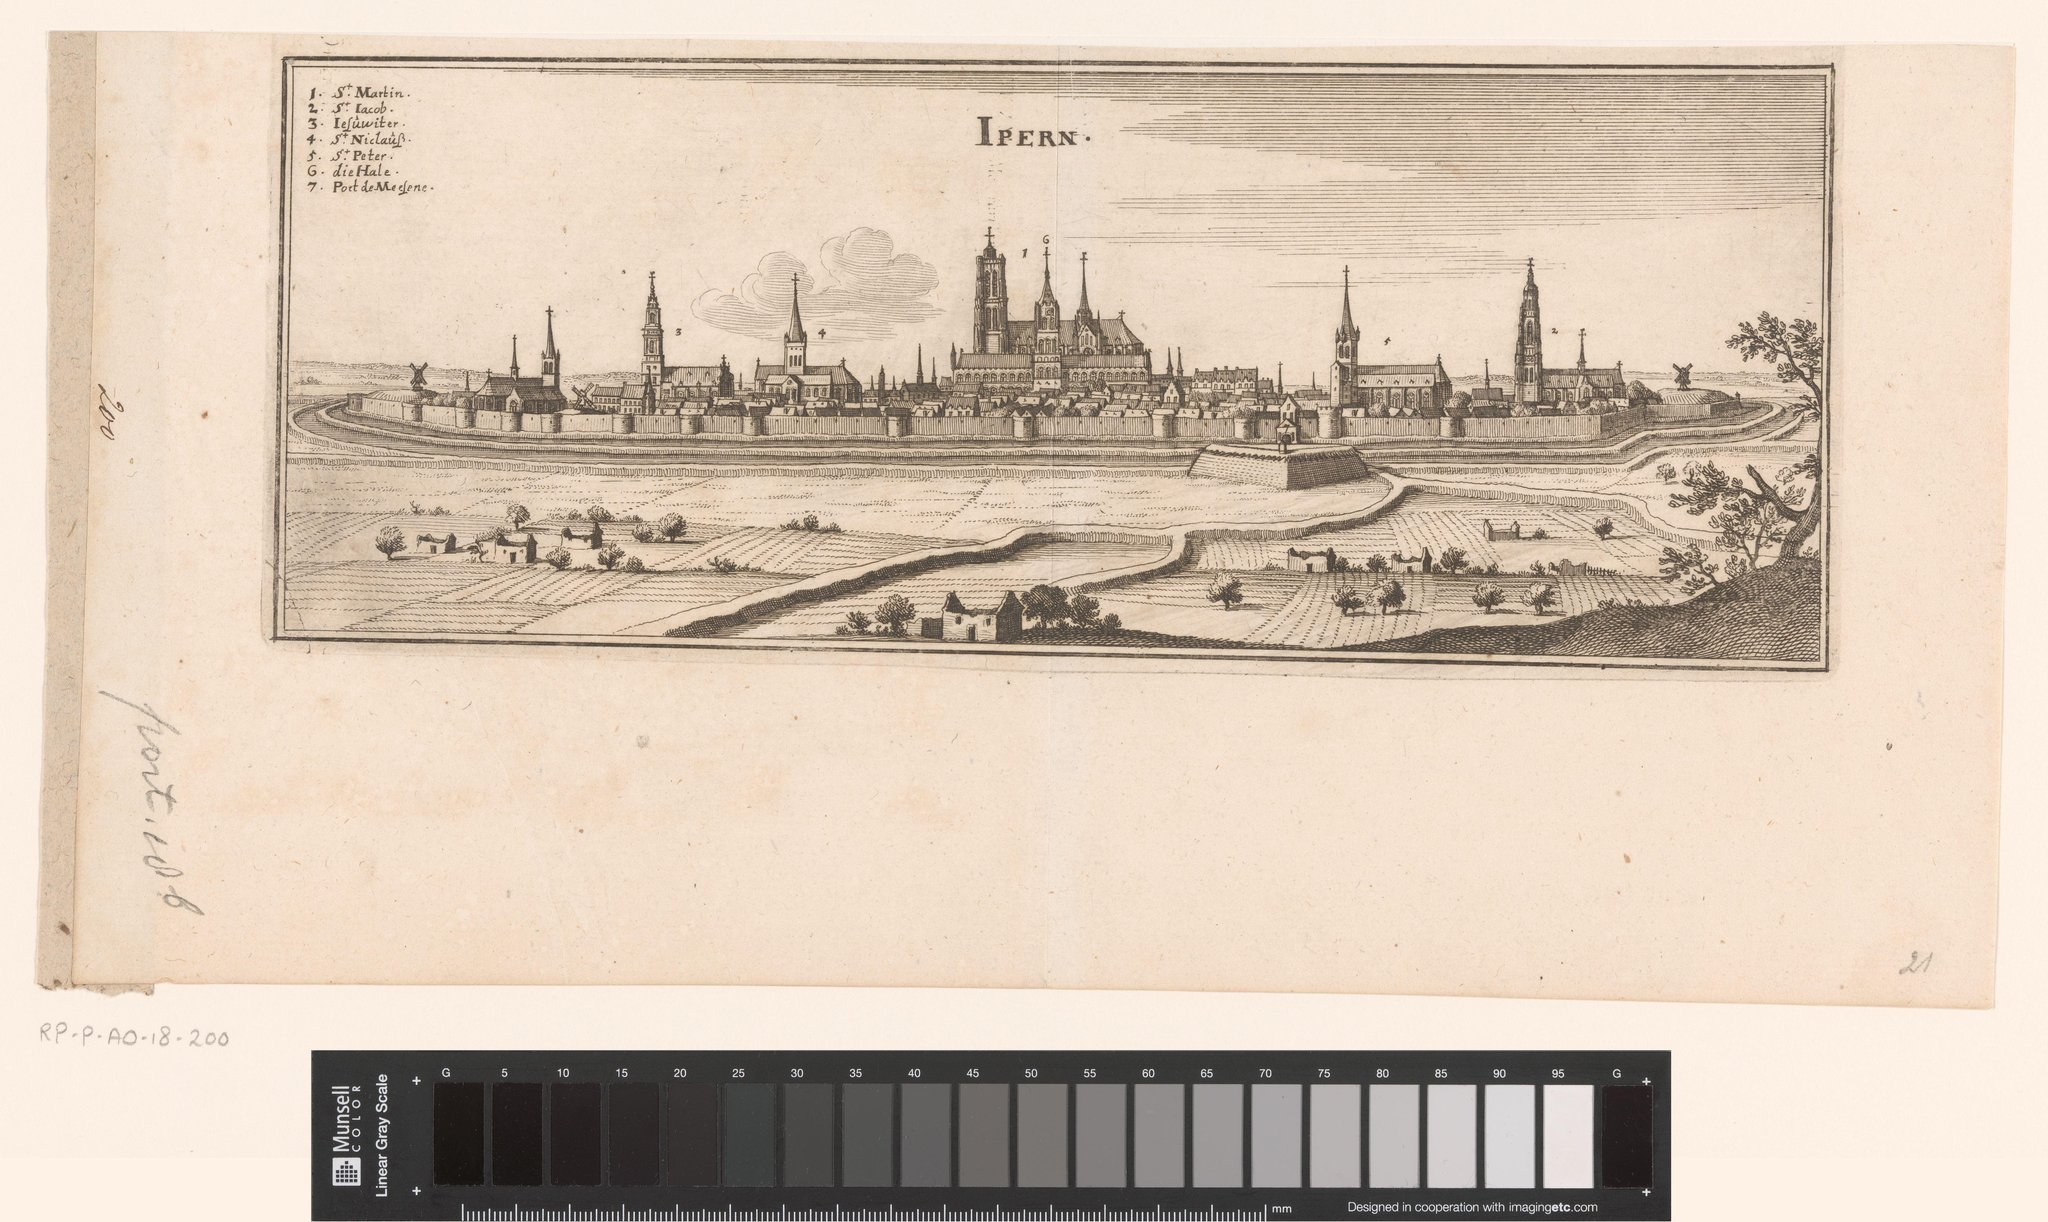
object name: print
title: Ipern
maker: caspar merian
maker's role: print maker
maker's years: 1627-1689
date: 1654-1700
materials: paper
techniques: engraving, etching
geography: frankfurt am main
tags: church (exterior), prospect of city, town panorama, silhouette of city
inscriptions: collector's mark: Lugt 2228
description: Prent gebruikt in: Zeiller, Martin. M.Z. Topographia Circuli Burgundici Oder Beschreibung une Eigentliche Abbildung der Vornehmsten Örter in dem Hochlöblichen Burgund- un Niderlandischen Crayse. Frankfurt am Main: Caspar Merian, 1654. Of in: Zeiller, Martin. M. Z. Topographia Germaniae-Inferioris vel Circuli-Burgundici, das ist Beschreibung (…). Frankfurt am Main: Caspar Merian, 1659. Of in een van de twee latere uitgaven van deze publicatie die, hoewel het jaar 1659 erin staat vermeld als jaar van uitgave, zijn uitgegeven in respectievelijk ca. 1670 en ca. 1700.